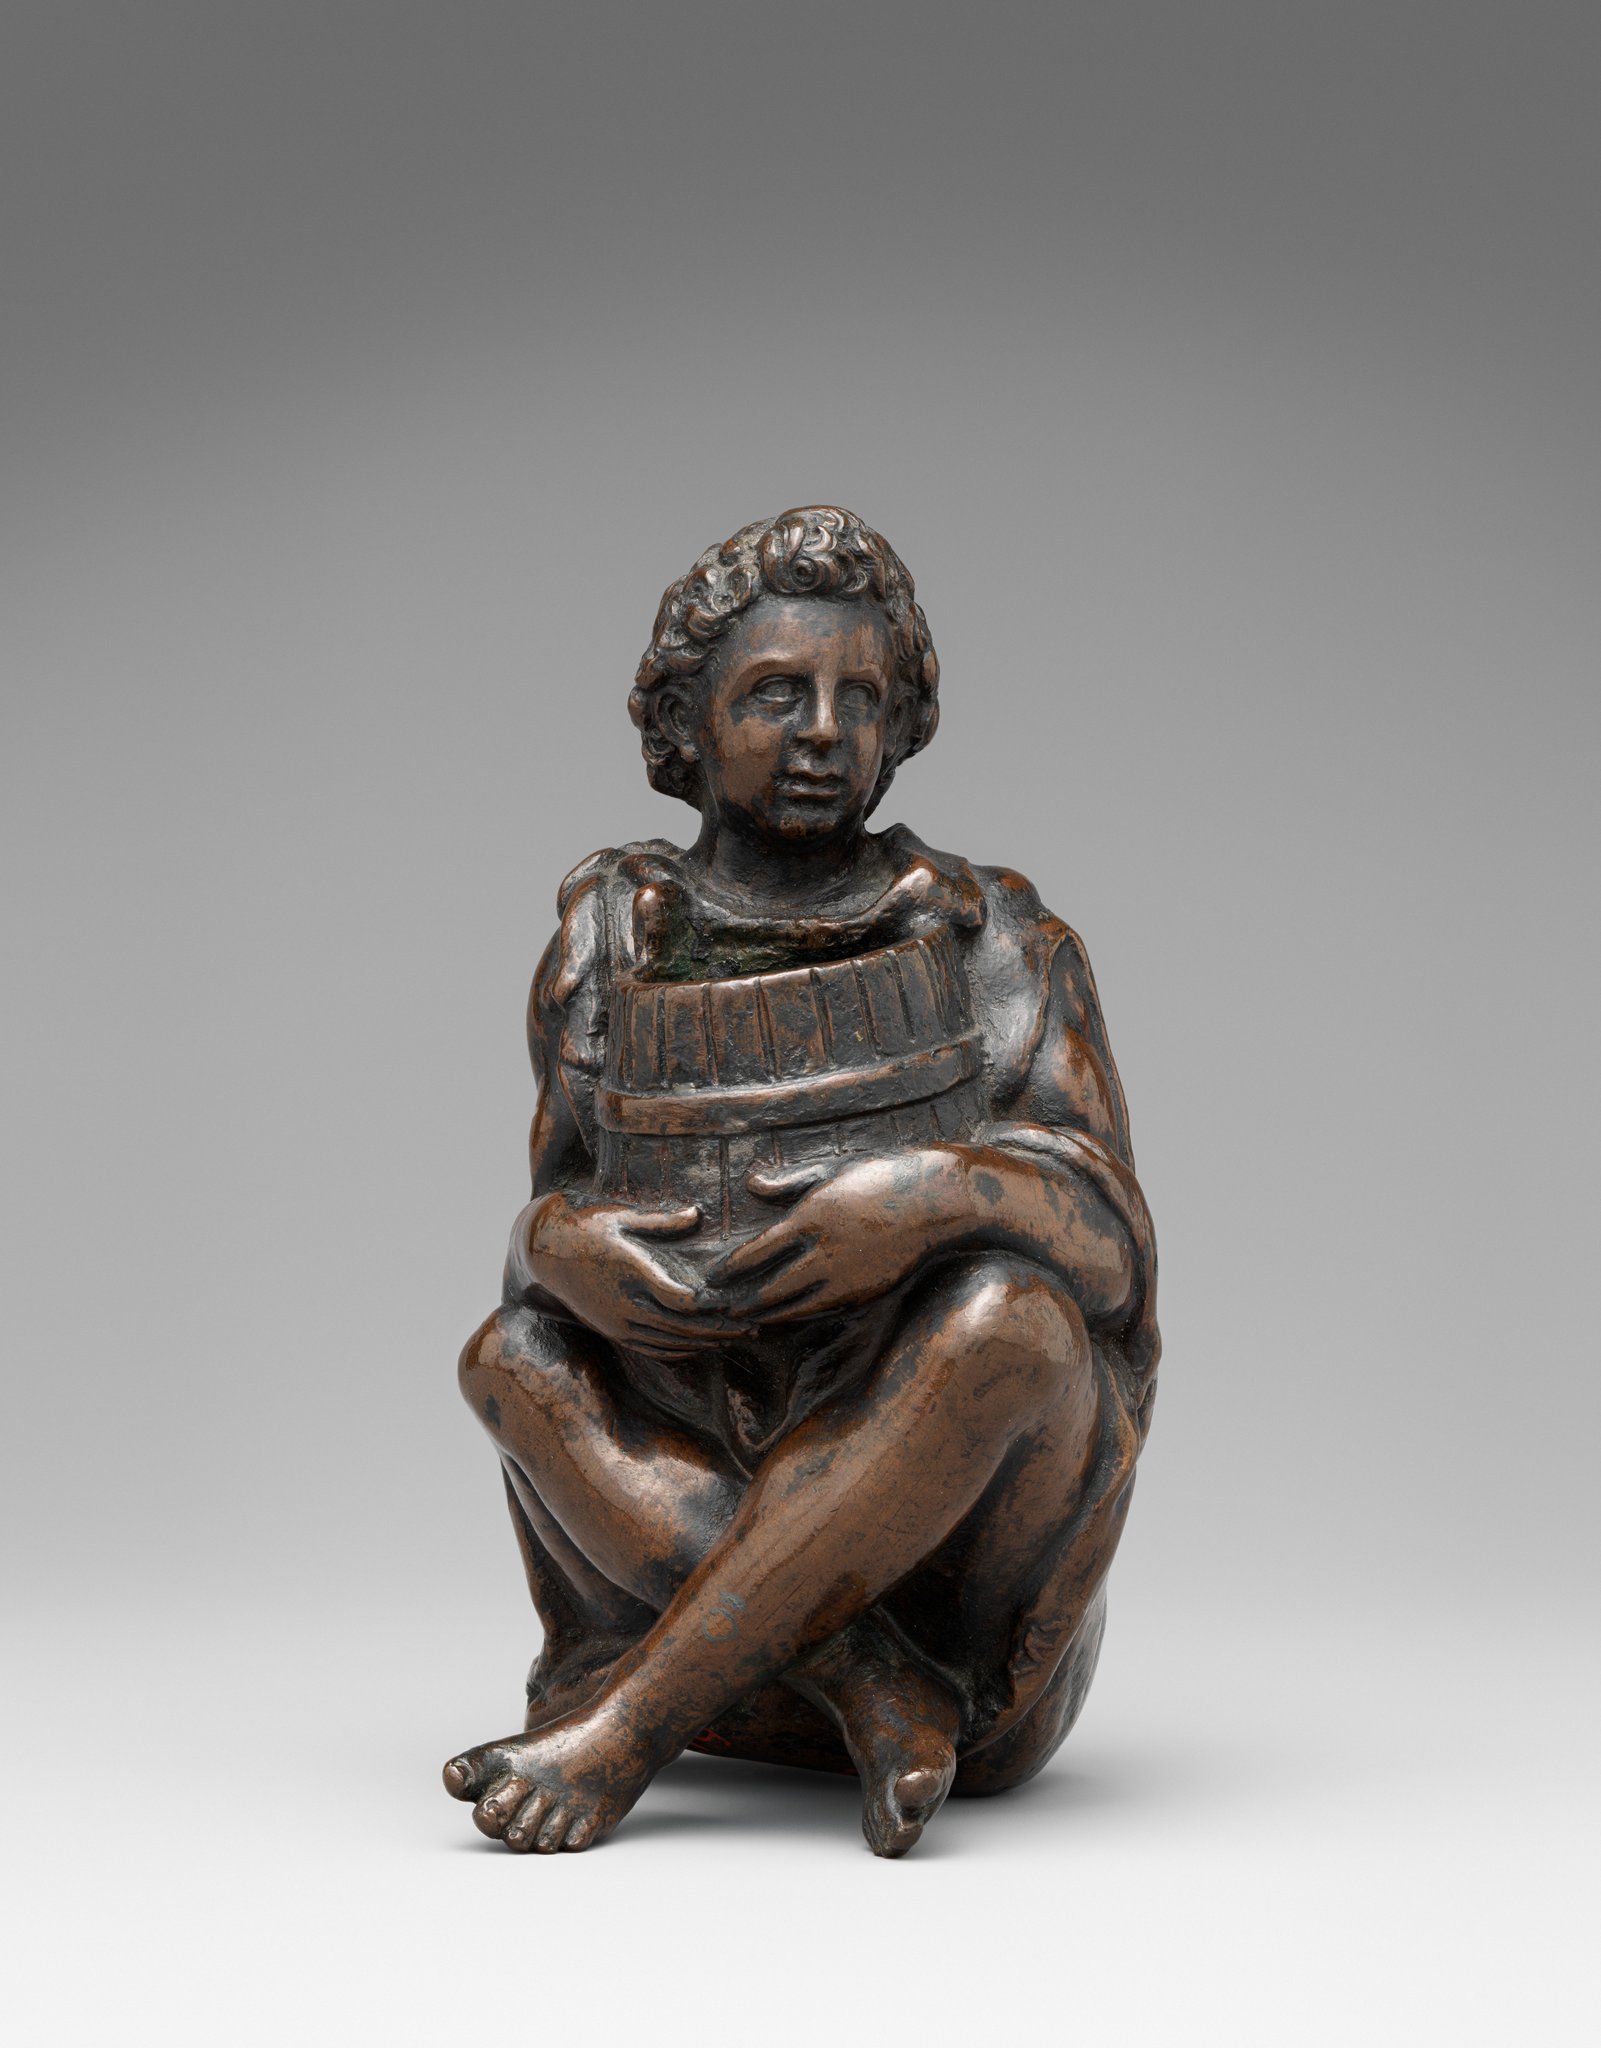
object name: inkstand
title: Boy with a barrel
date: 1501-1600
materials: bronze, lacquer, patina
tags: boys,barrels